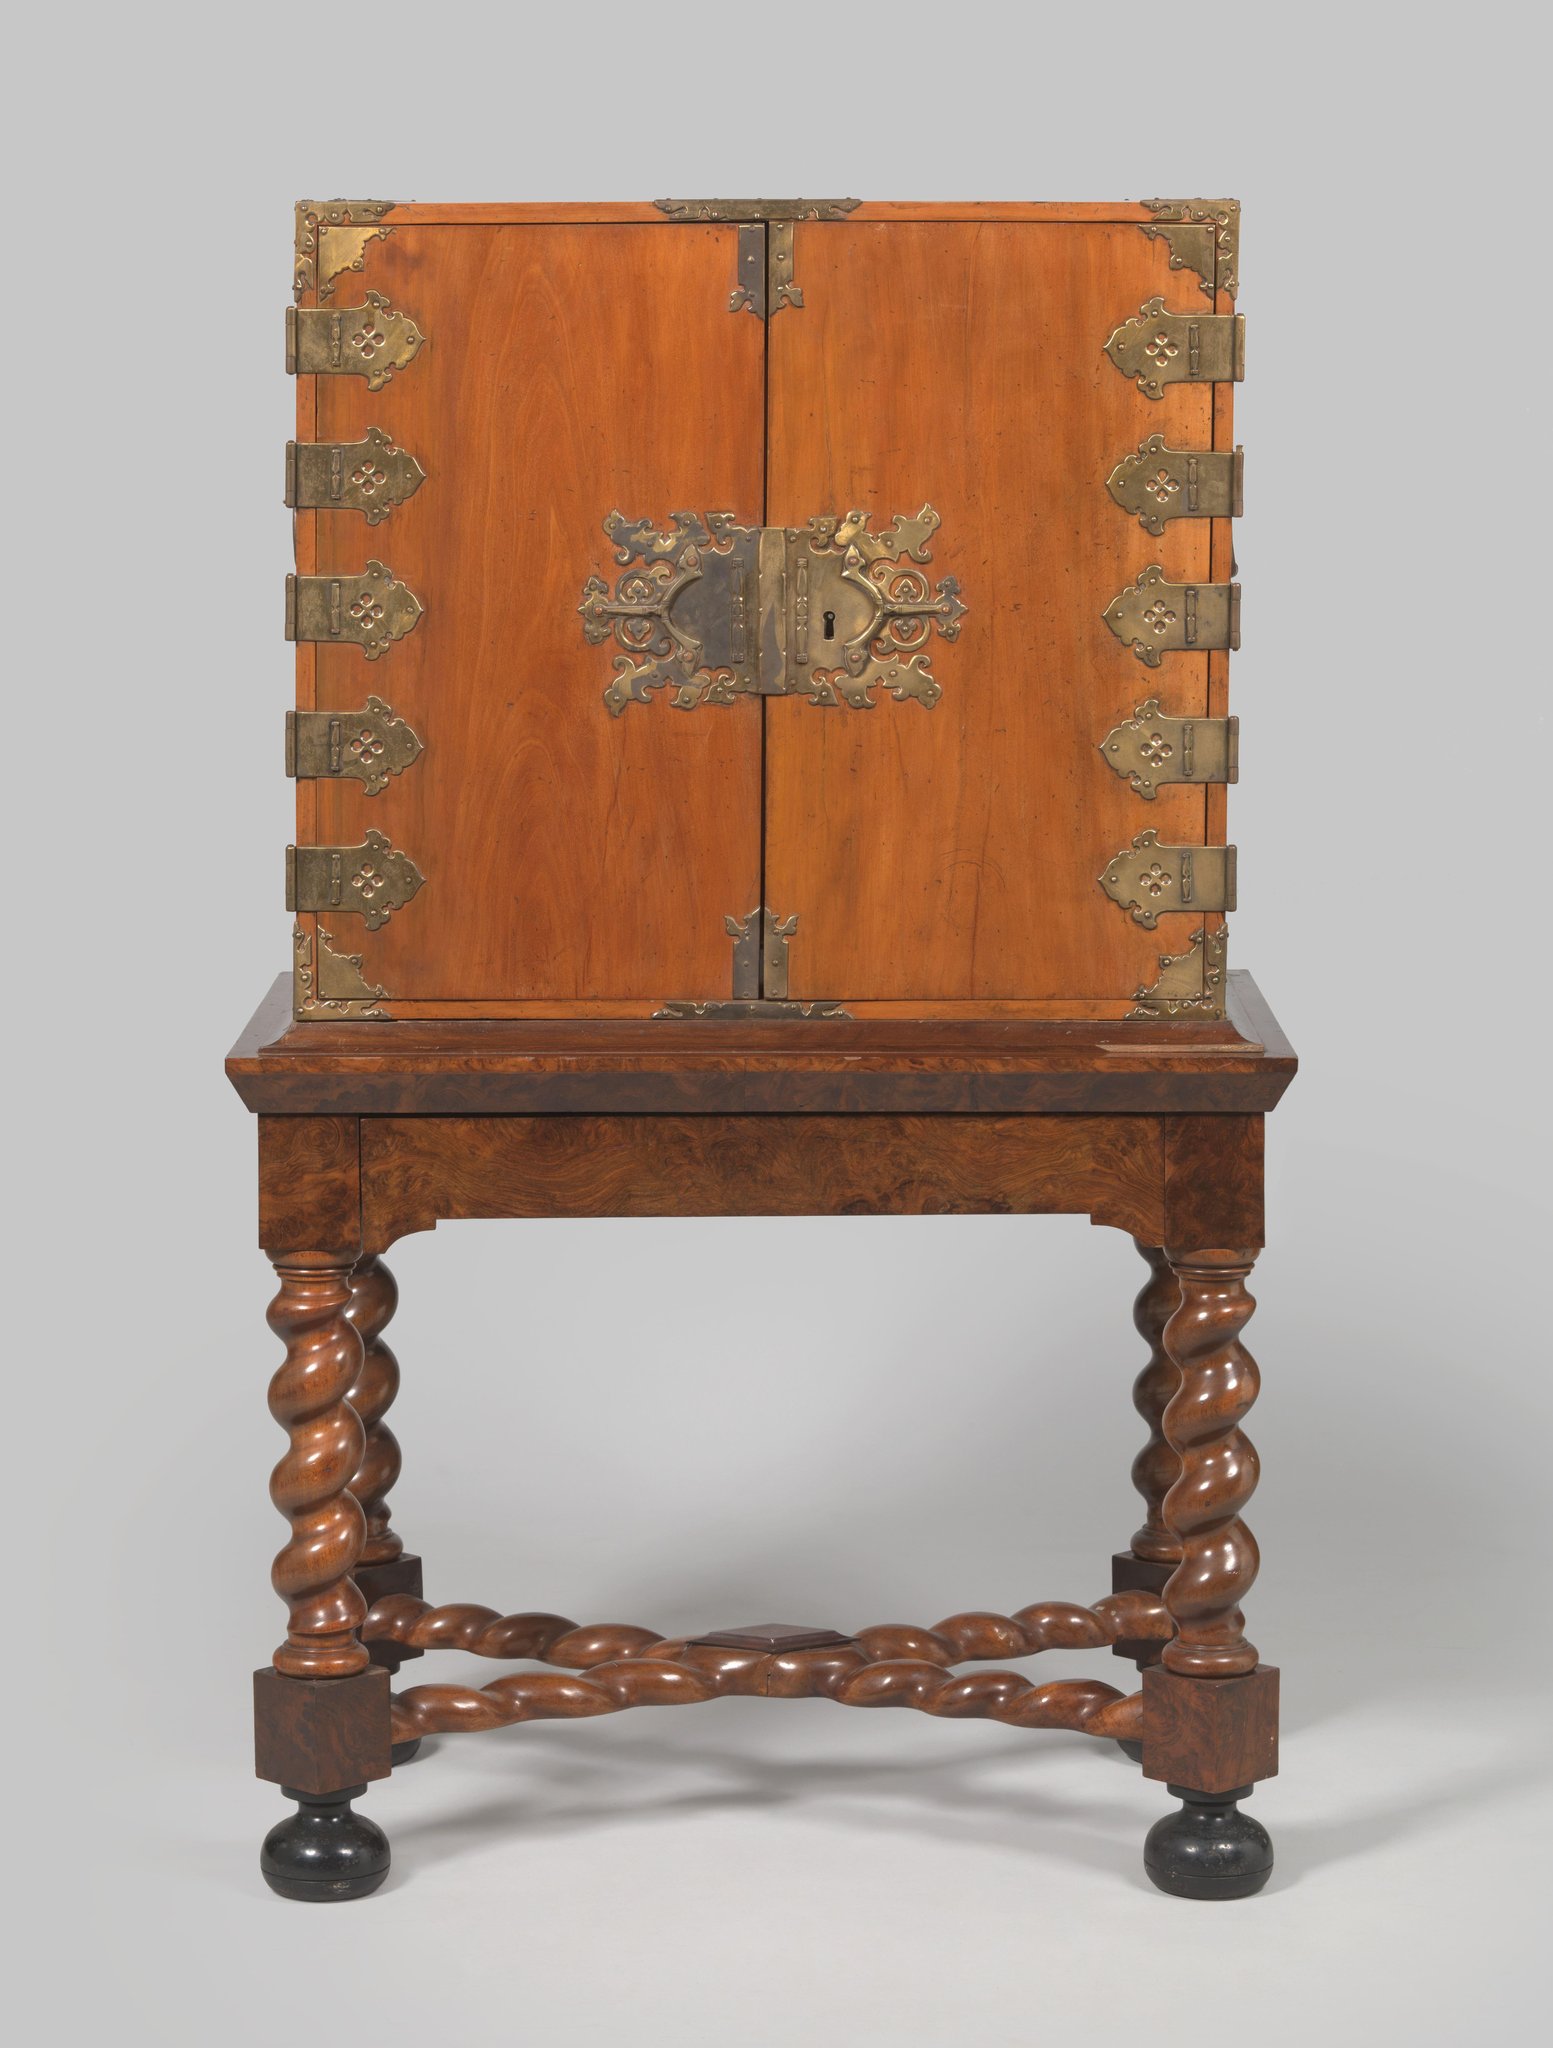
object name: case furniture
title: Kast van Indonesisch hout op onderstel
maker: Anonymous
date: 1650-1700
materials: copper, iron, wood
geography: indonesia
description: Kast van Indonesisch hout, rustend op een onderstel belijmd met wortelnotenhout. De slotplaat, hoekstukken en scharnieren zijn van gesmeed koper. Aan de zijkanten ijzeren handvatten met koperen platen. Achter de beide frontdeuren bevinden zich meerdere laden met koperen trekkers op stervormige platen. Het onderstel heeft geslingerde poten, verbonden door een aan de onderzijde afgeplat geslingerd X-vormig kruis, en rust op platte zwarte bollen. In de regel is een schuiflade aangebracht.